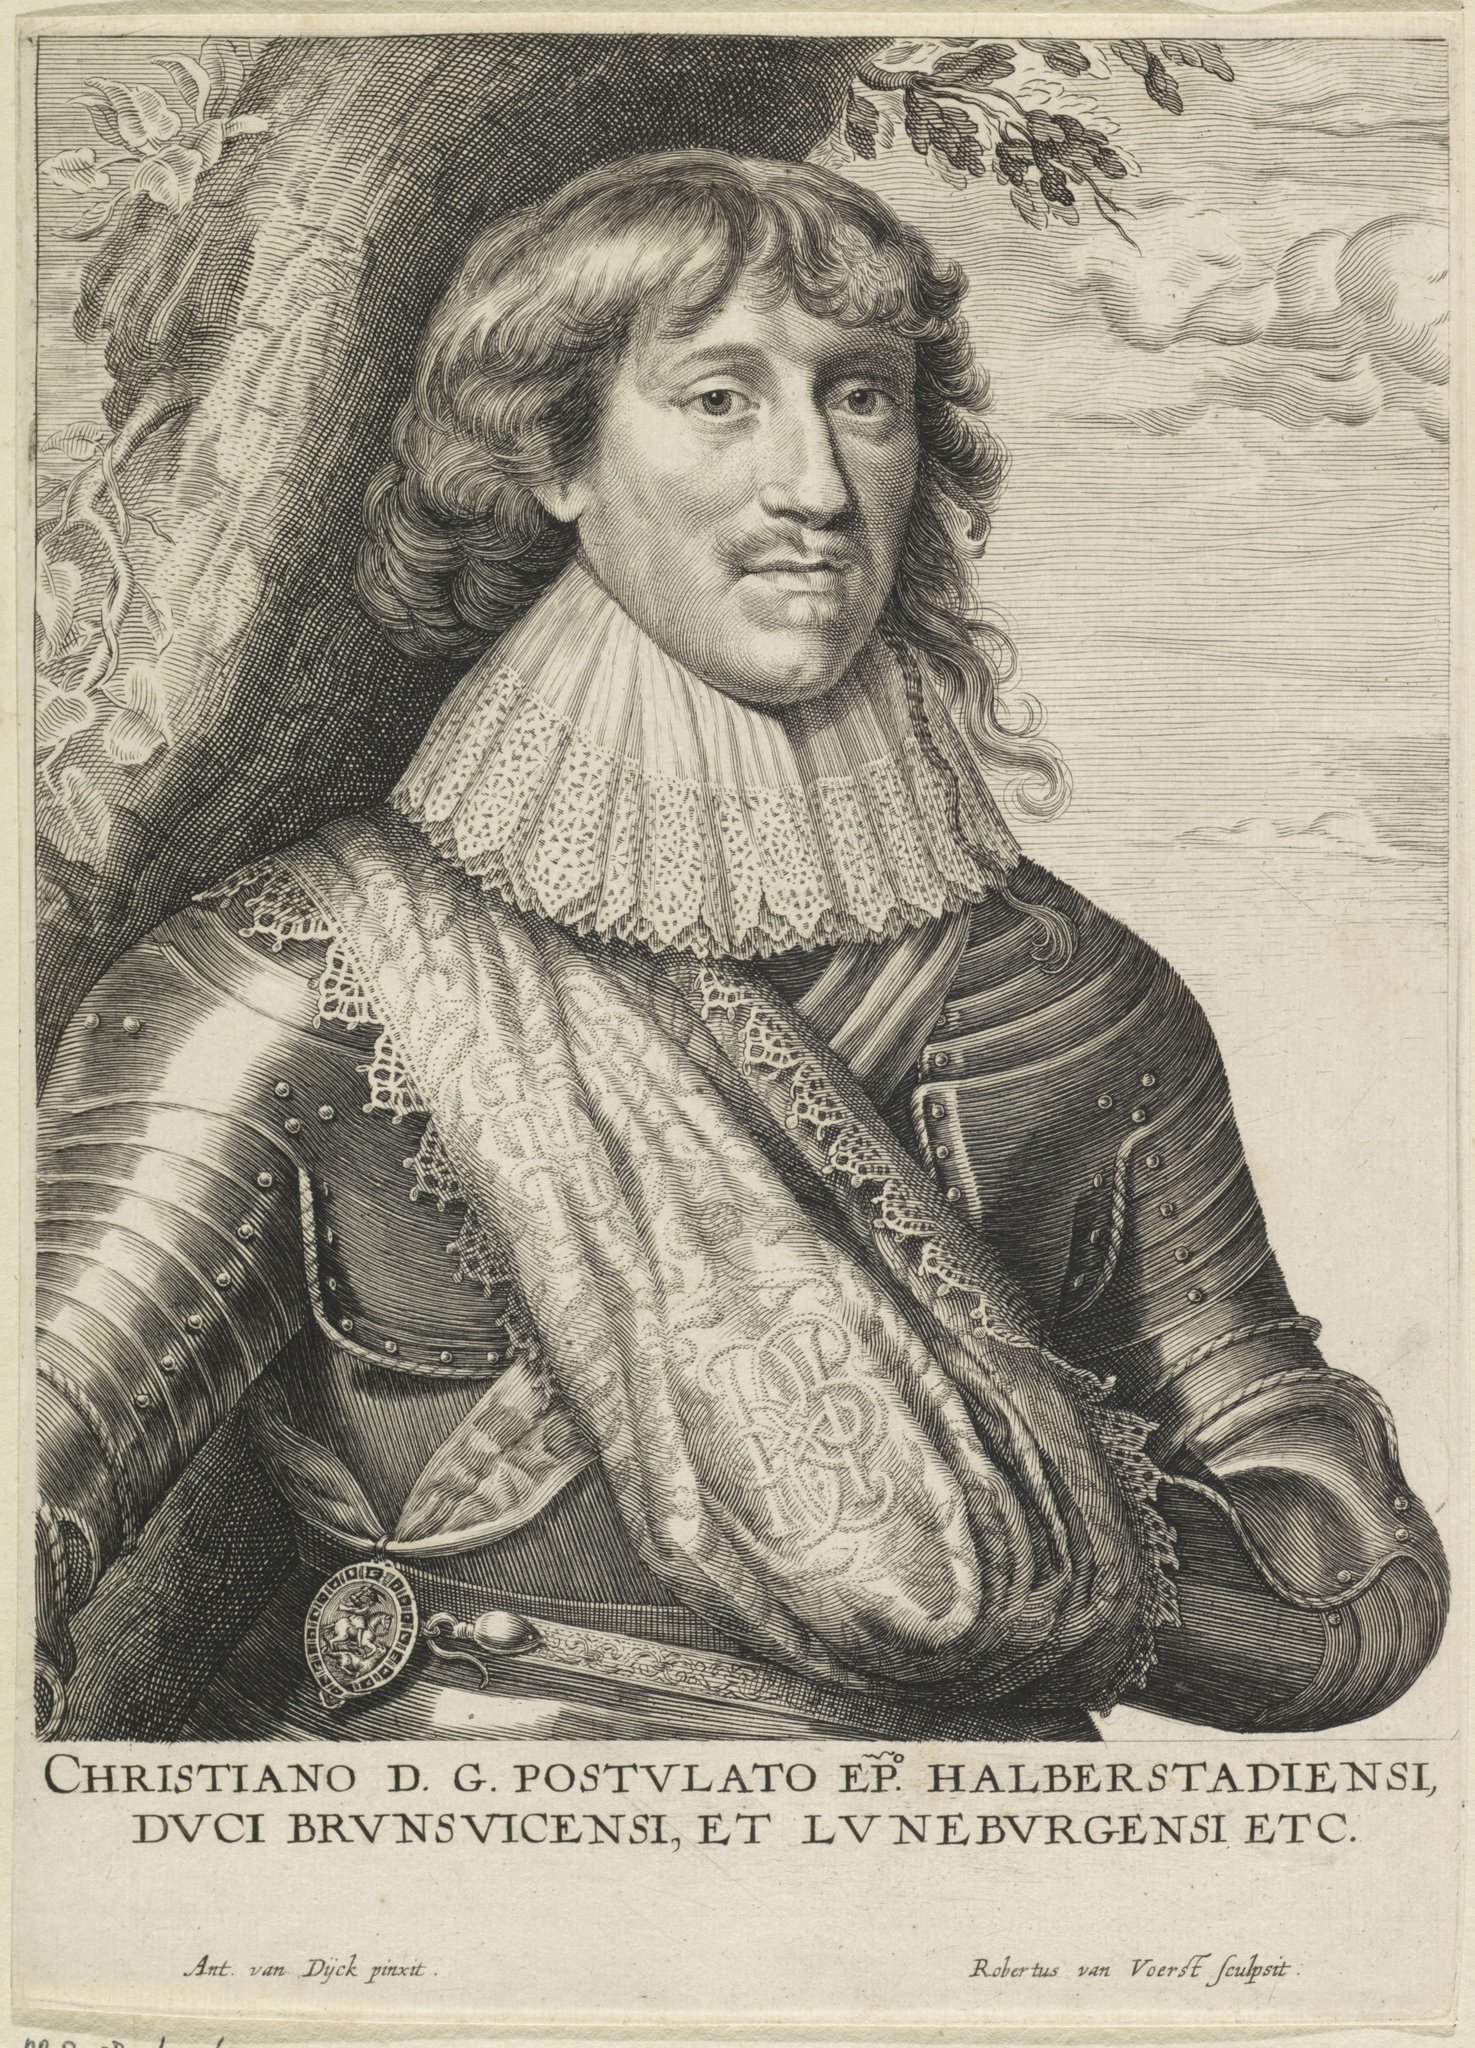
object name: print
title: Portret van Christiaan, hertog van Brunswijk-Wolfenbüttel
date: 1625-1636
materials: paper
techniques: engraving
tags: armour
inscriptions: collector's mark: Lugt 240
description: Portret van Christiaan, hertog van Brunswijk en Lüneburg, militair leider in de strijd tegen de Habsburgers en de Katholieke Liga tijdens de Dertigjarige Oorlog.